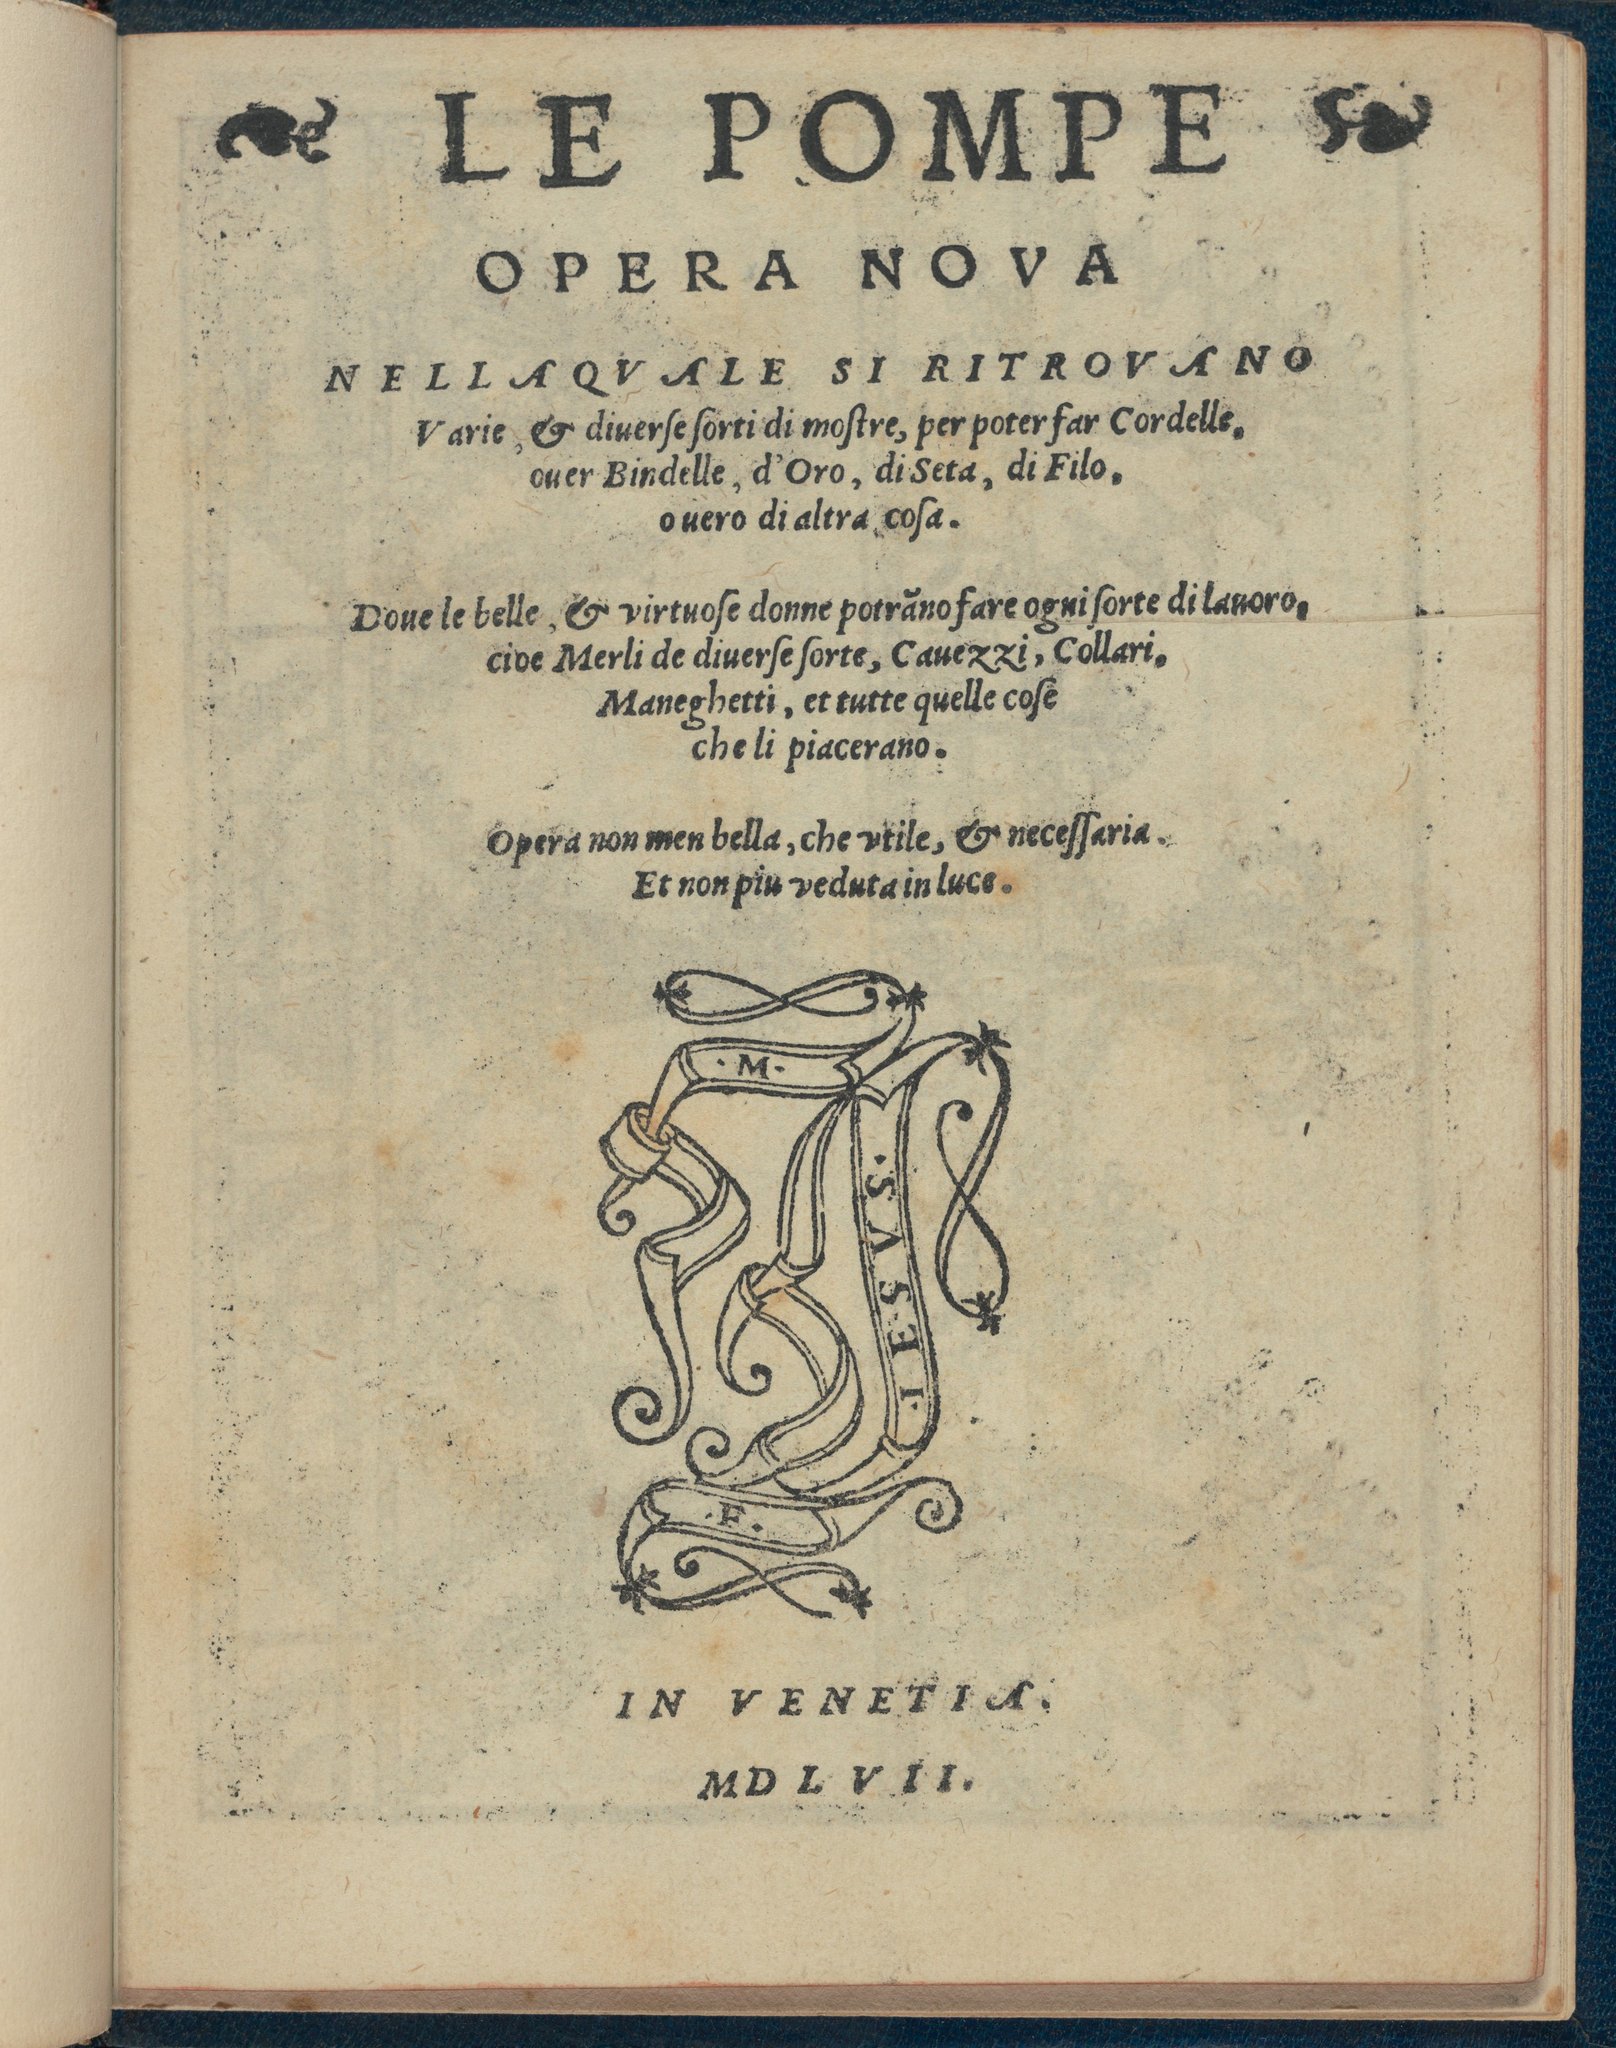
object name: book print ornament architecture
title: Le Pompe: Opera Nova, title page (recto)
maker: giovanni battista & marchio sessa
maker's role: publisher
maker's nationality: italian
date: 1557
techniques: woodcut